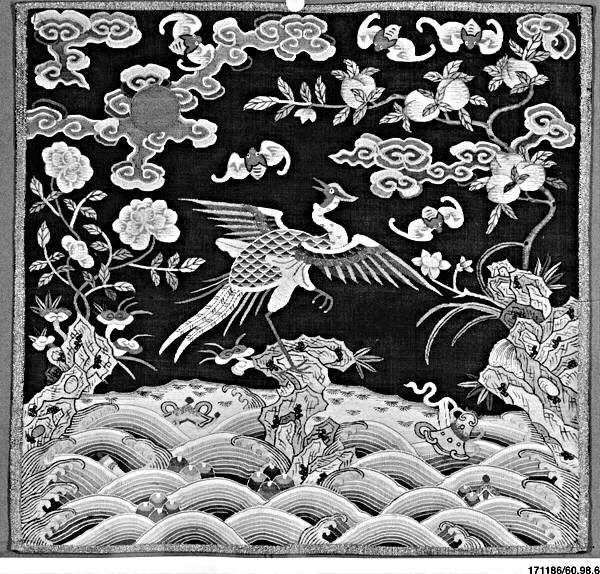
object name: rank badge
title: Rank Badge with Golden Pheasant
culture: chinese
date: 1901-1950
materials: metal thread, silk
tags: bats,pheasants